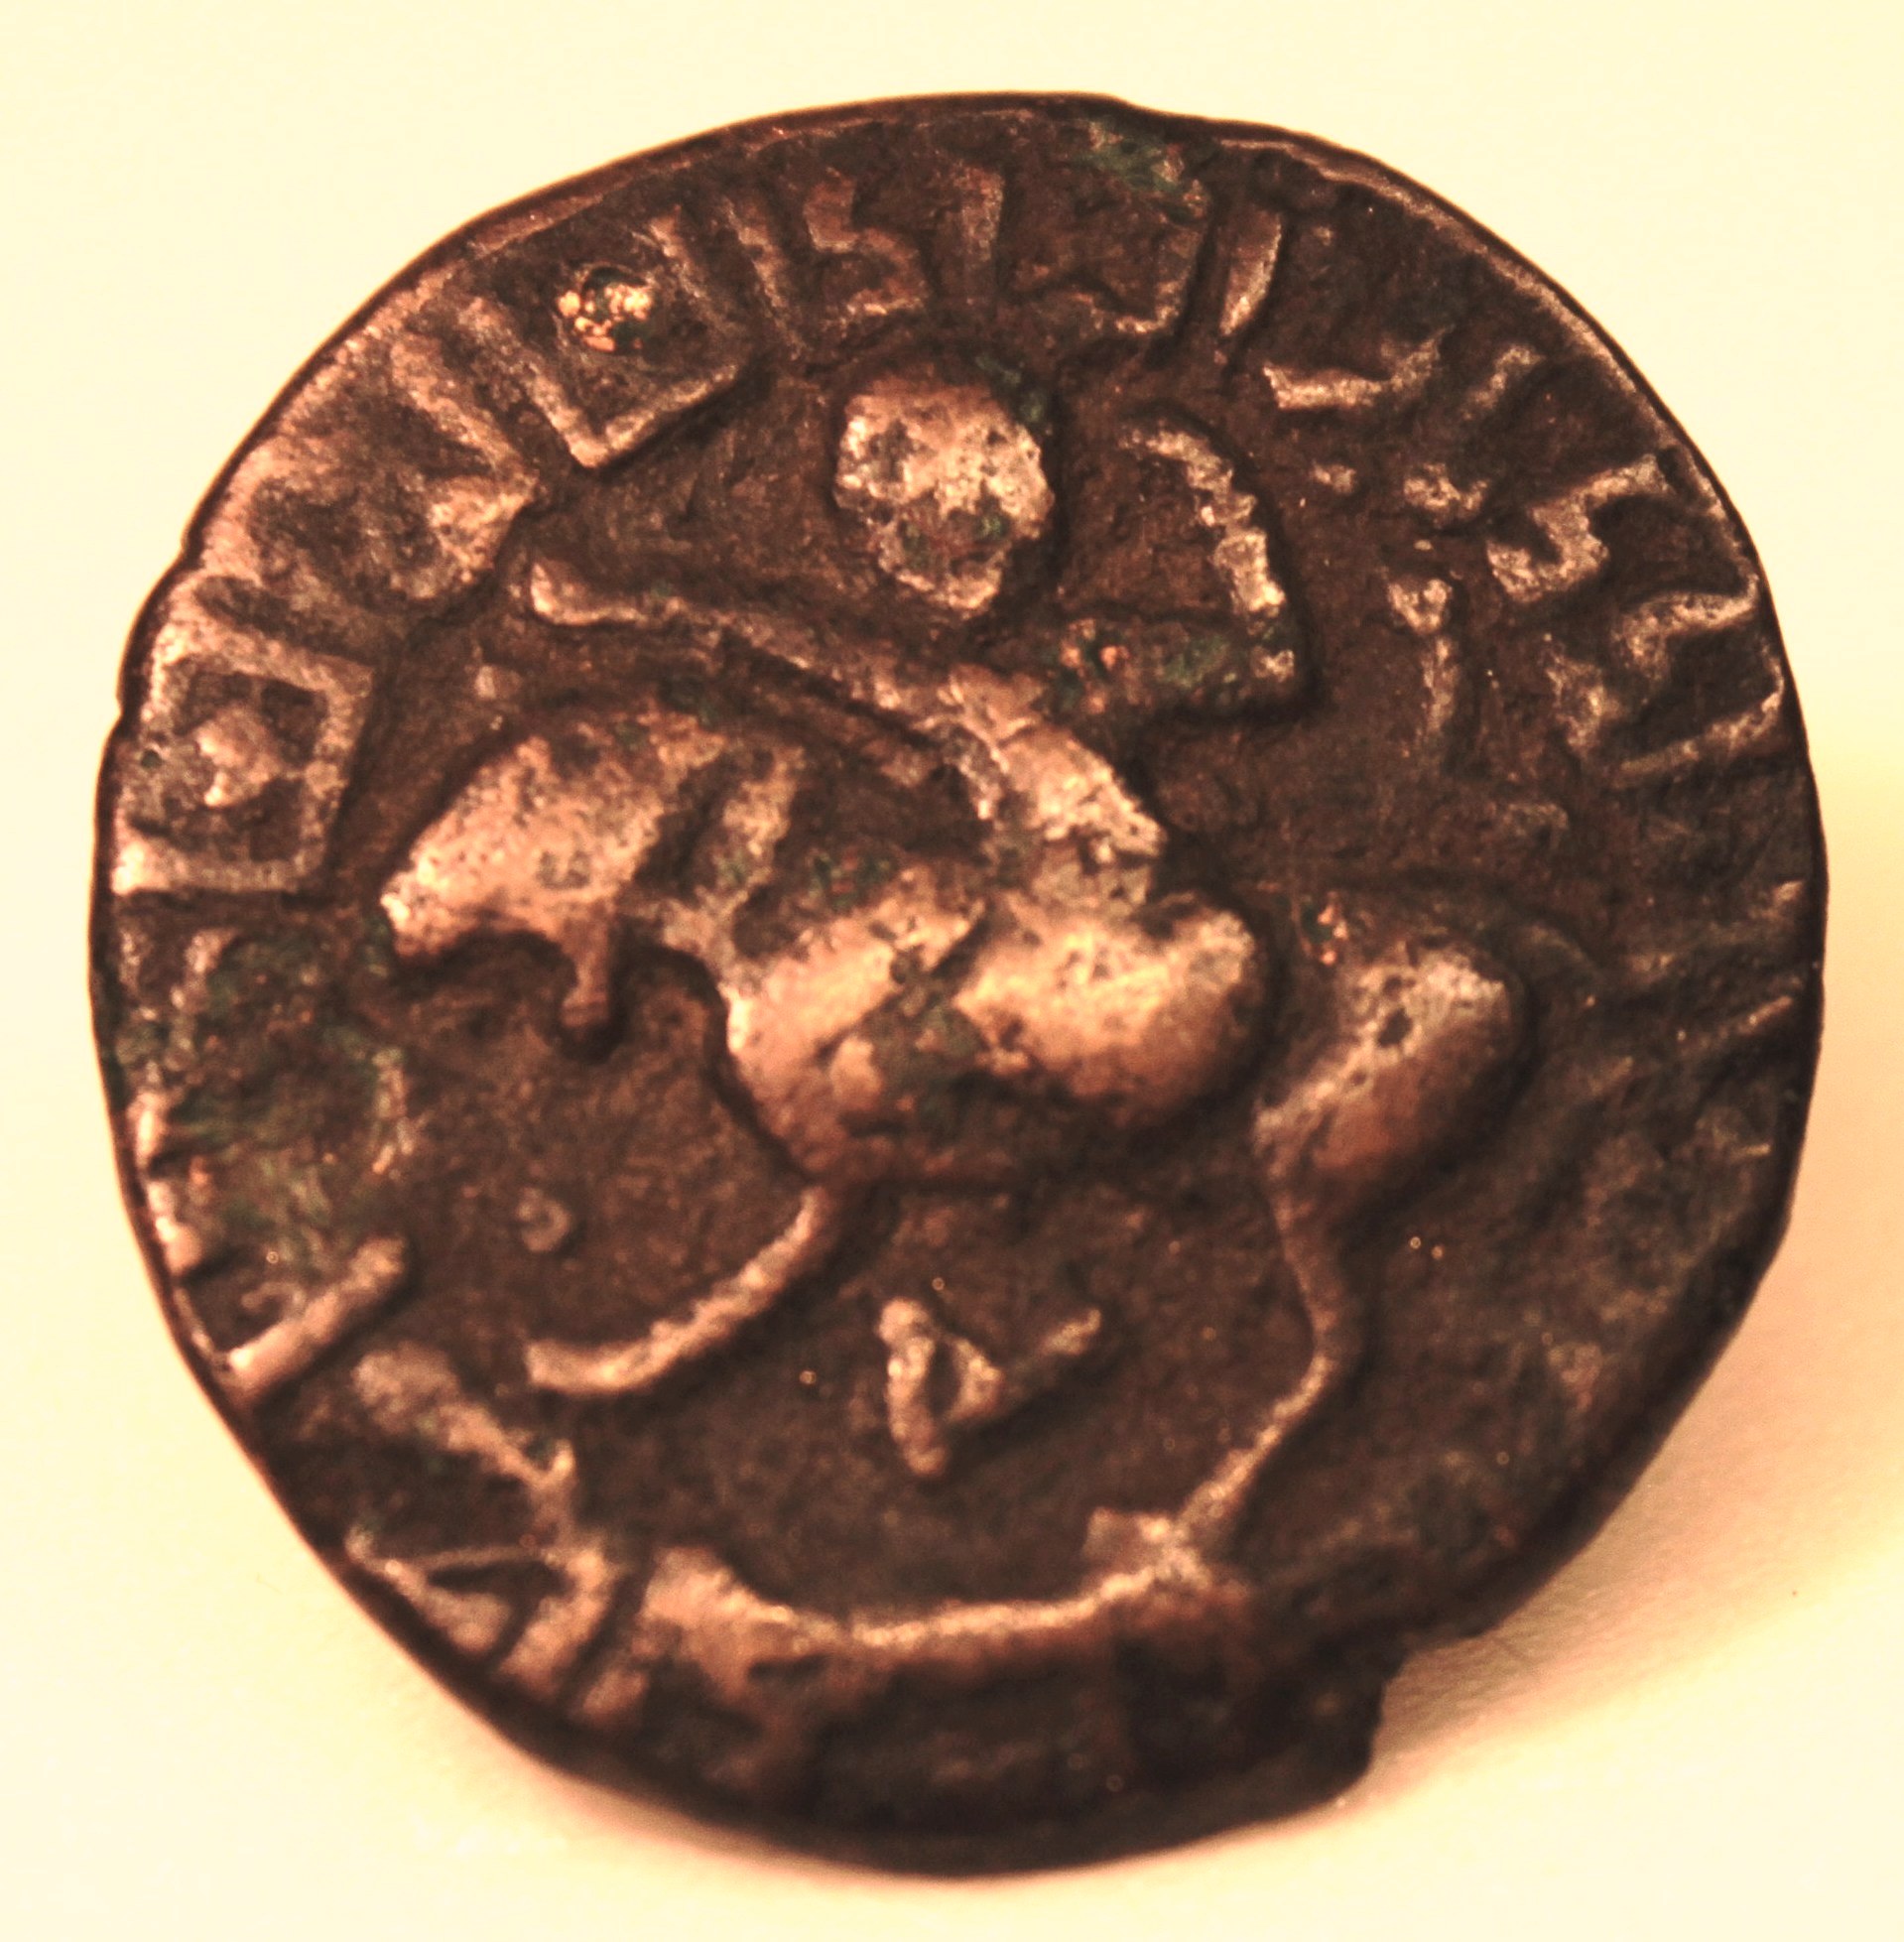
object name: coin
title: Dirham of Nasir al-Din Artuq Arslan (r. 1200-1239)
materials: copper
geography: turkey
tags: human figures,animals